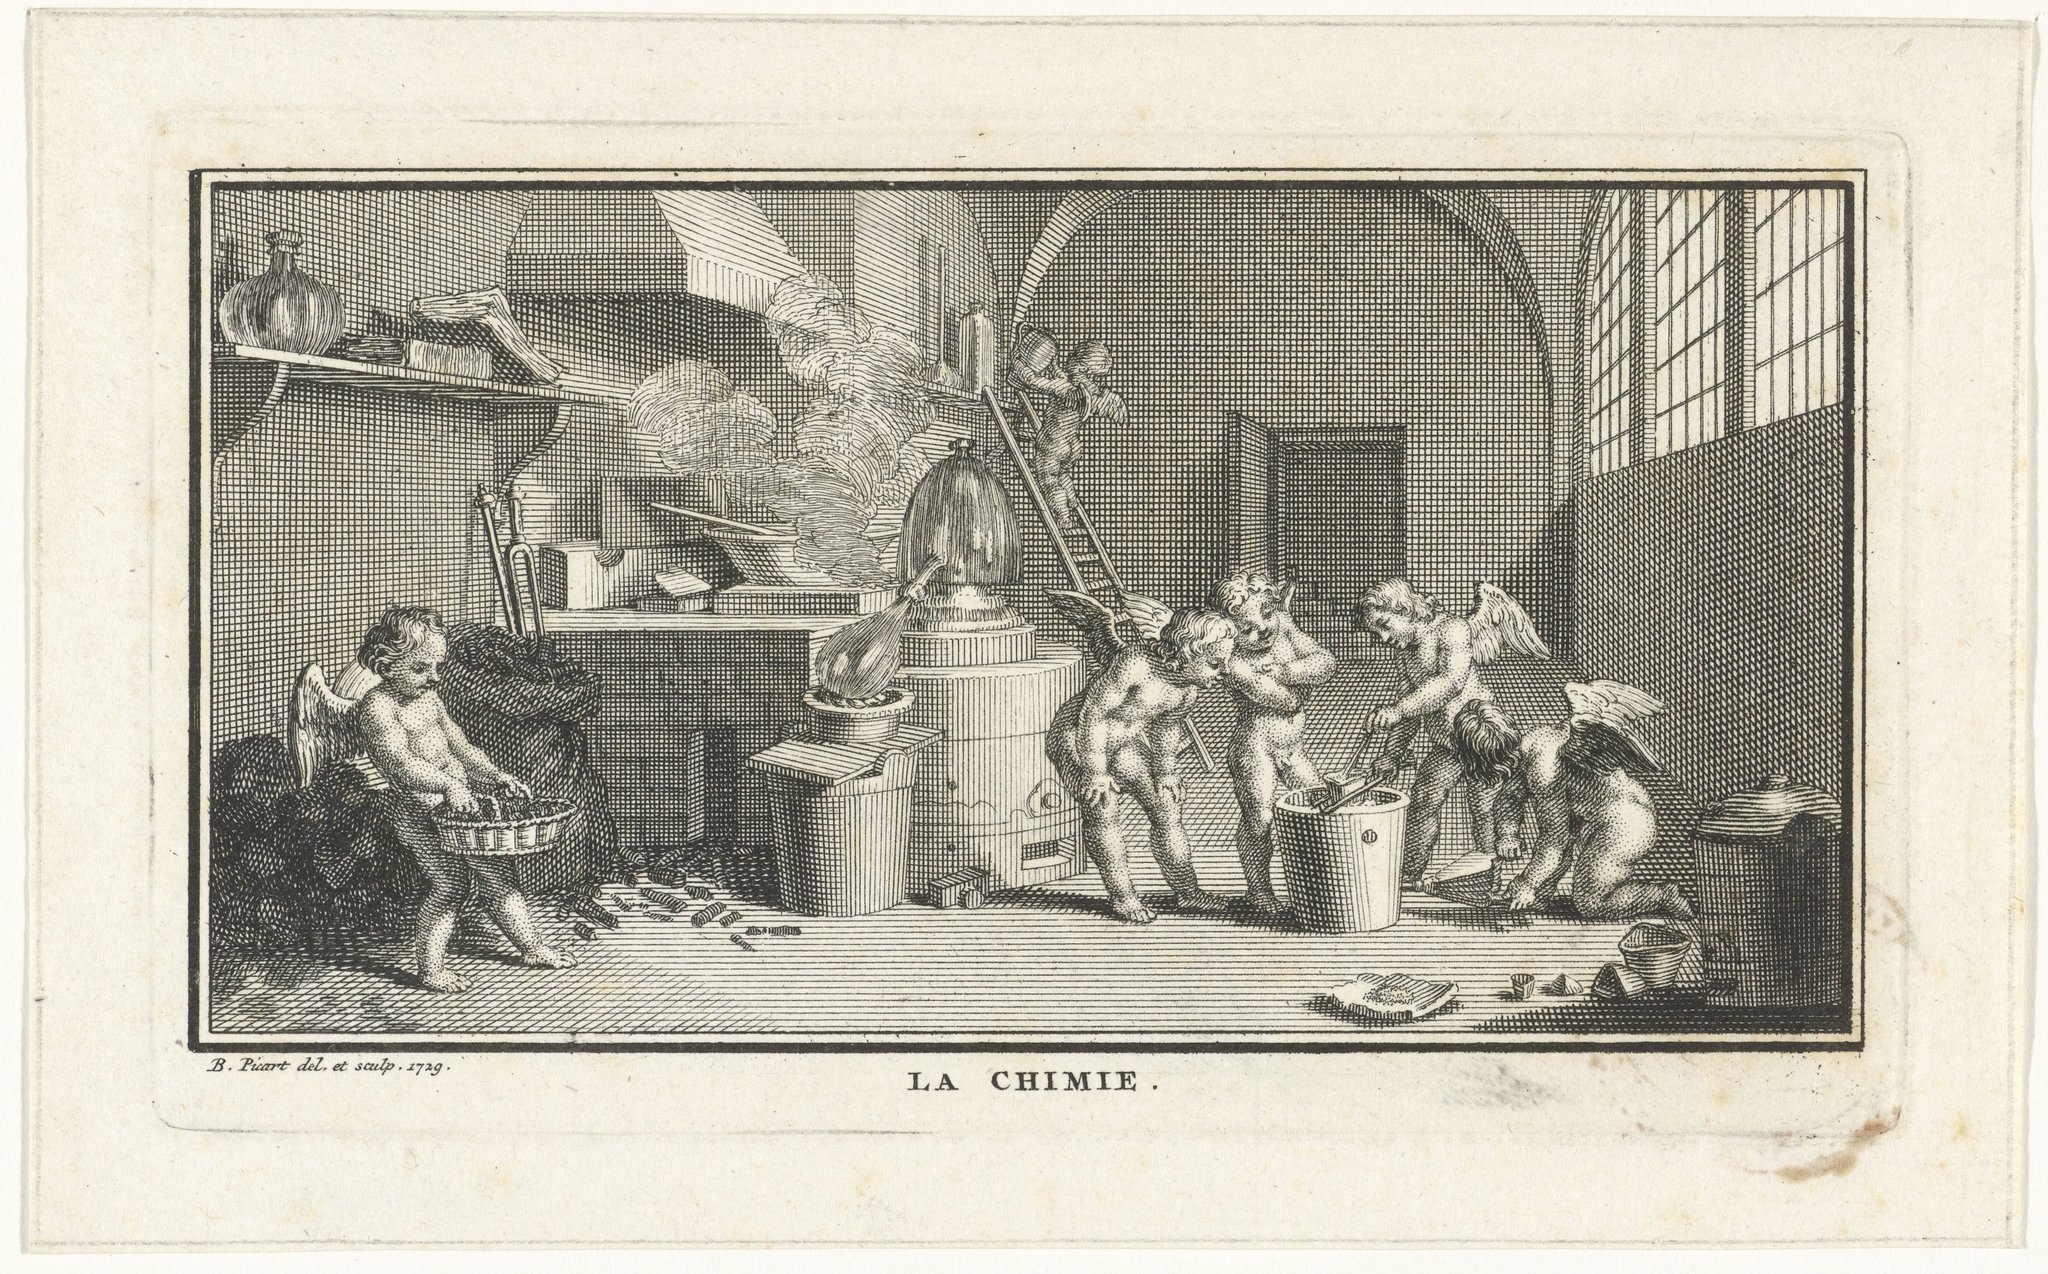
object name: print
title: Allegorie op de scheikunde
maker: bernard picart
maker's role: draughtsman, print maker, publisher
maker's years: 1673-1733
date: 1729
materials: paper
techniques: engraving, etching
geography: amsterdam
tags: chemistry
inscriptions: collector's mark: Lugt 240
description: Prent ook gebruikt als illustratie in: Fontenelle, Bernard Le Bovier de. Oeuvres diverses. Den Haag: Pierre Gosse en Jean Neaulme, 1728-1729.